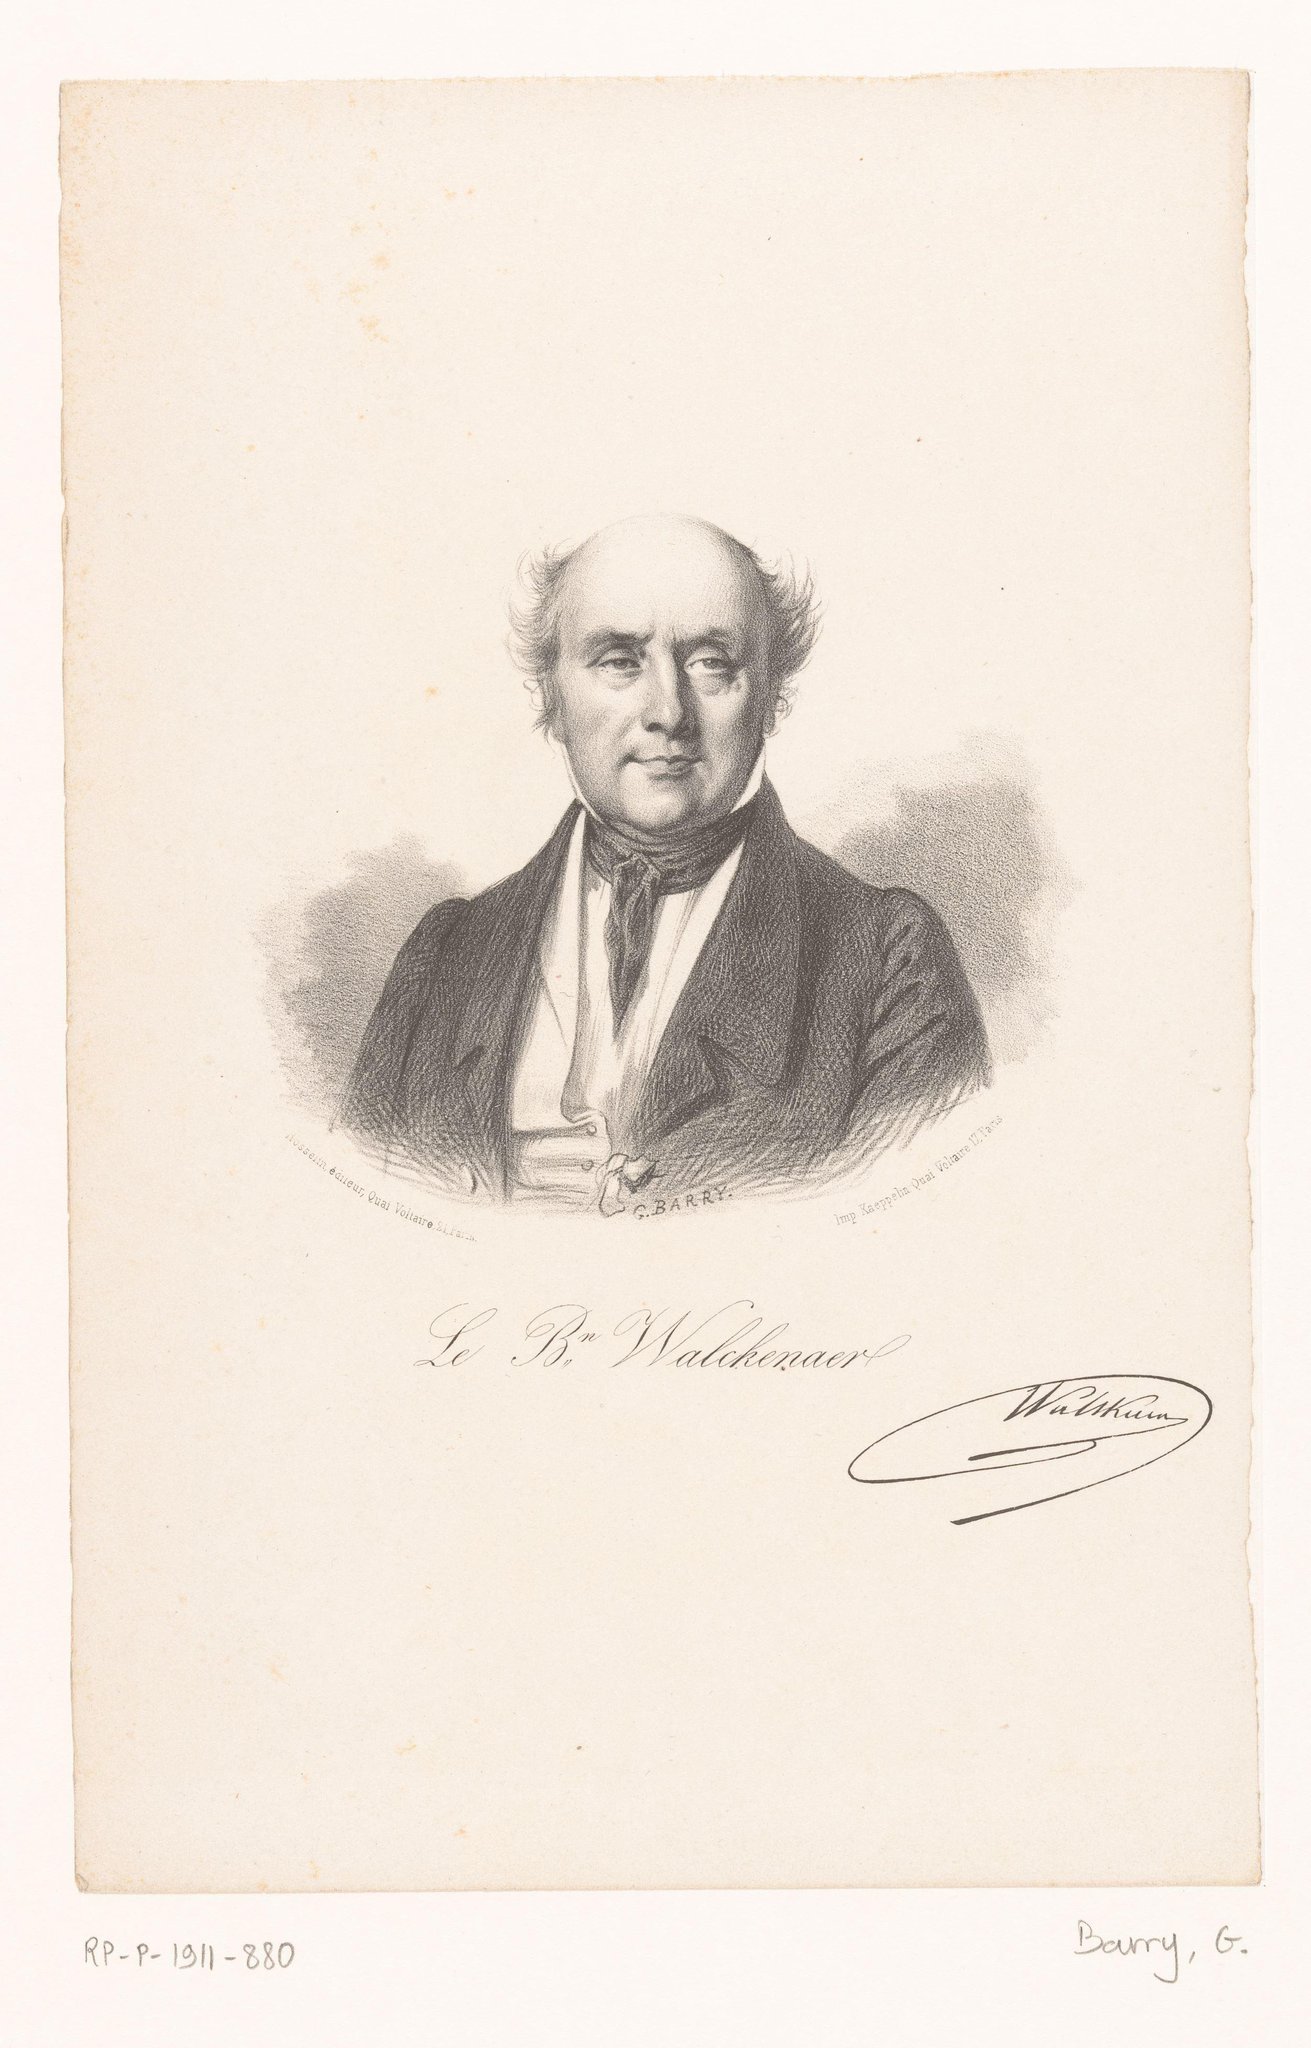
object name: print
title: Le bn. Walckenaer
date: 1853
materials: paper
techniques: lithograph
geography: paris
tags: paris, historical persons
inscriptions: collector's mark: Lugt 2228a